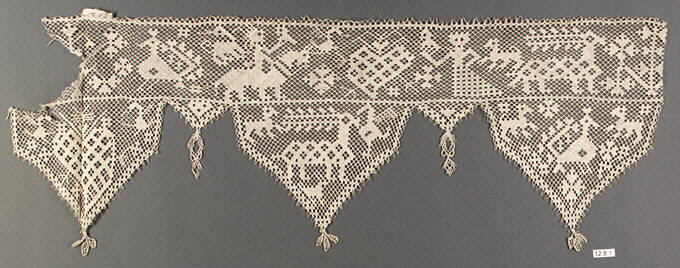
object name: network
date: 1601-1700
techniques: embroidery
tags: animals